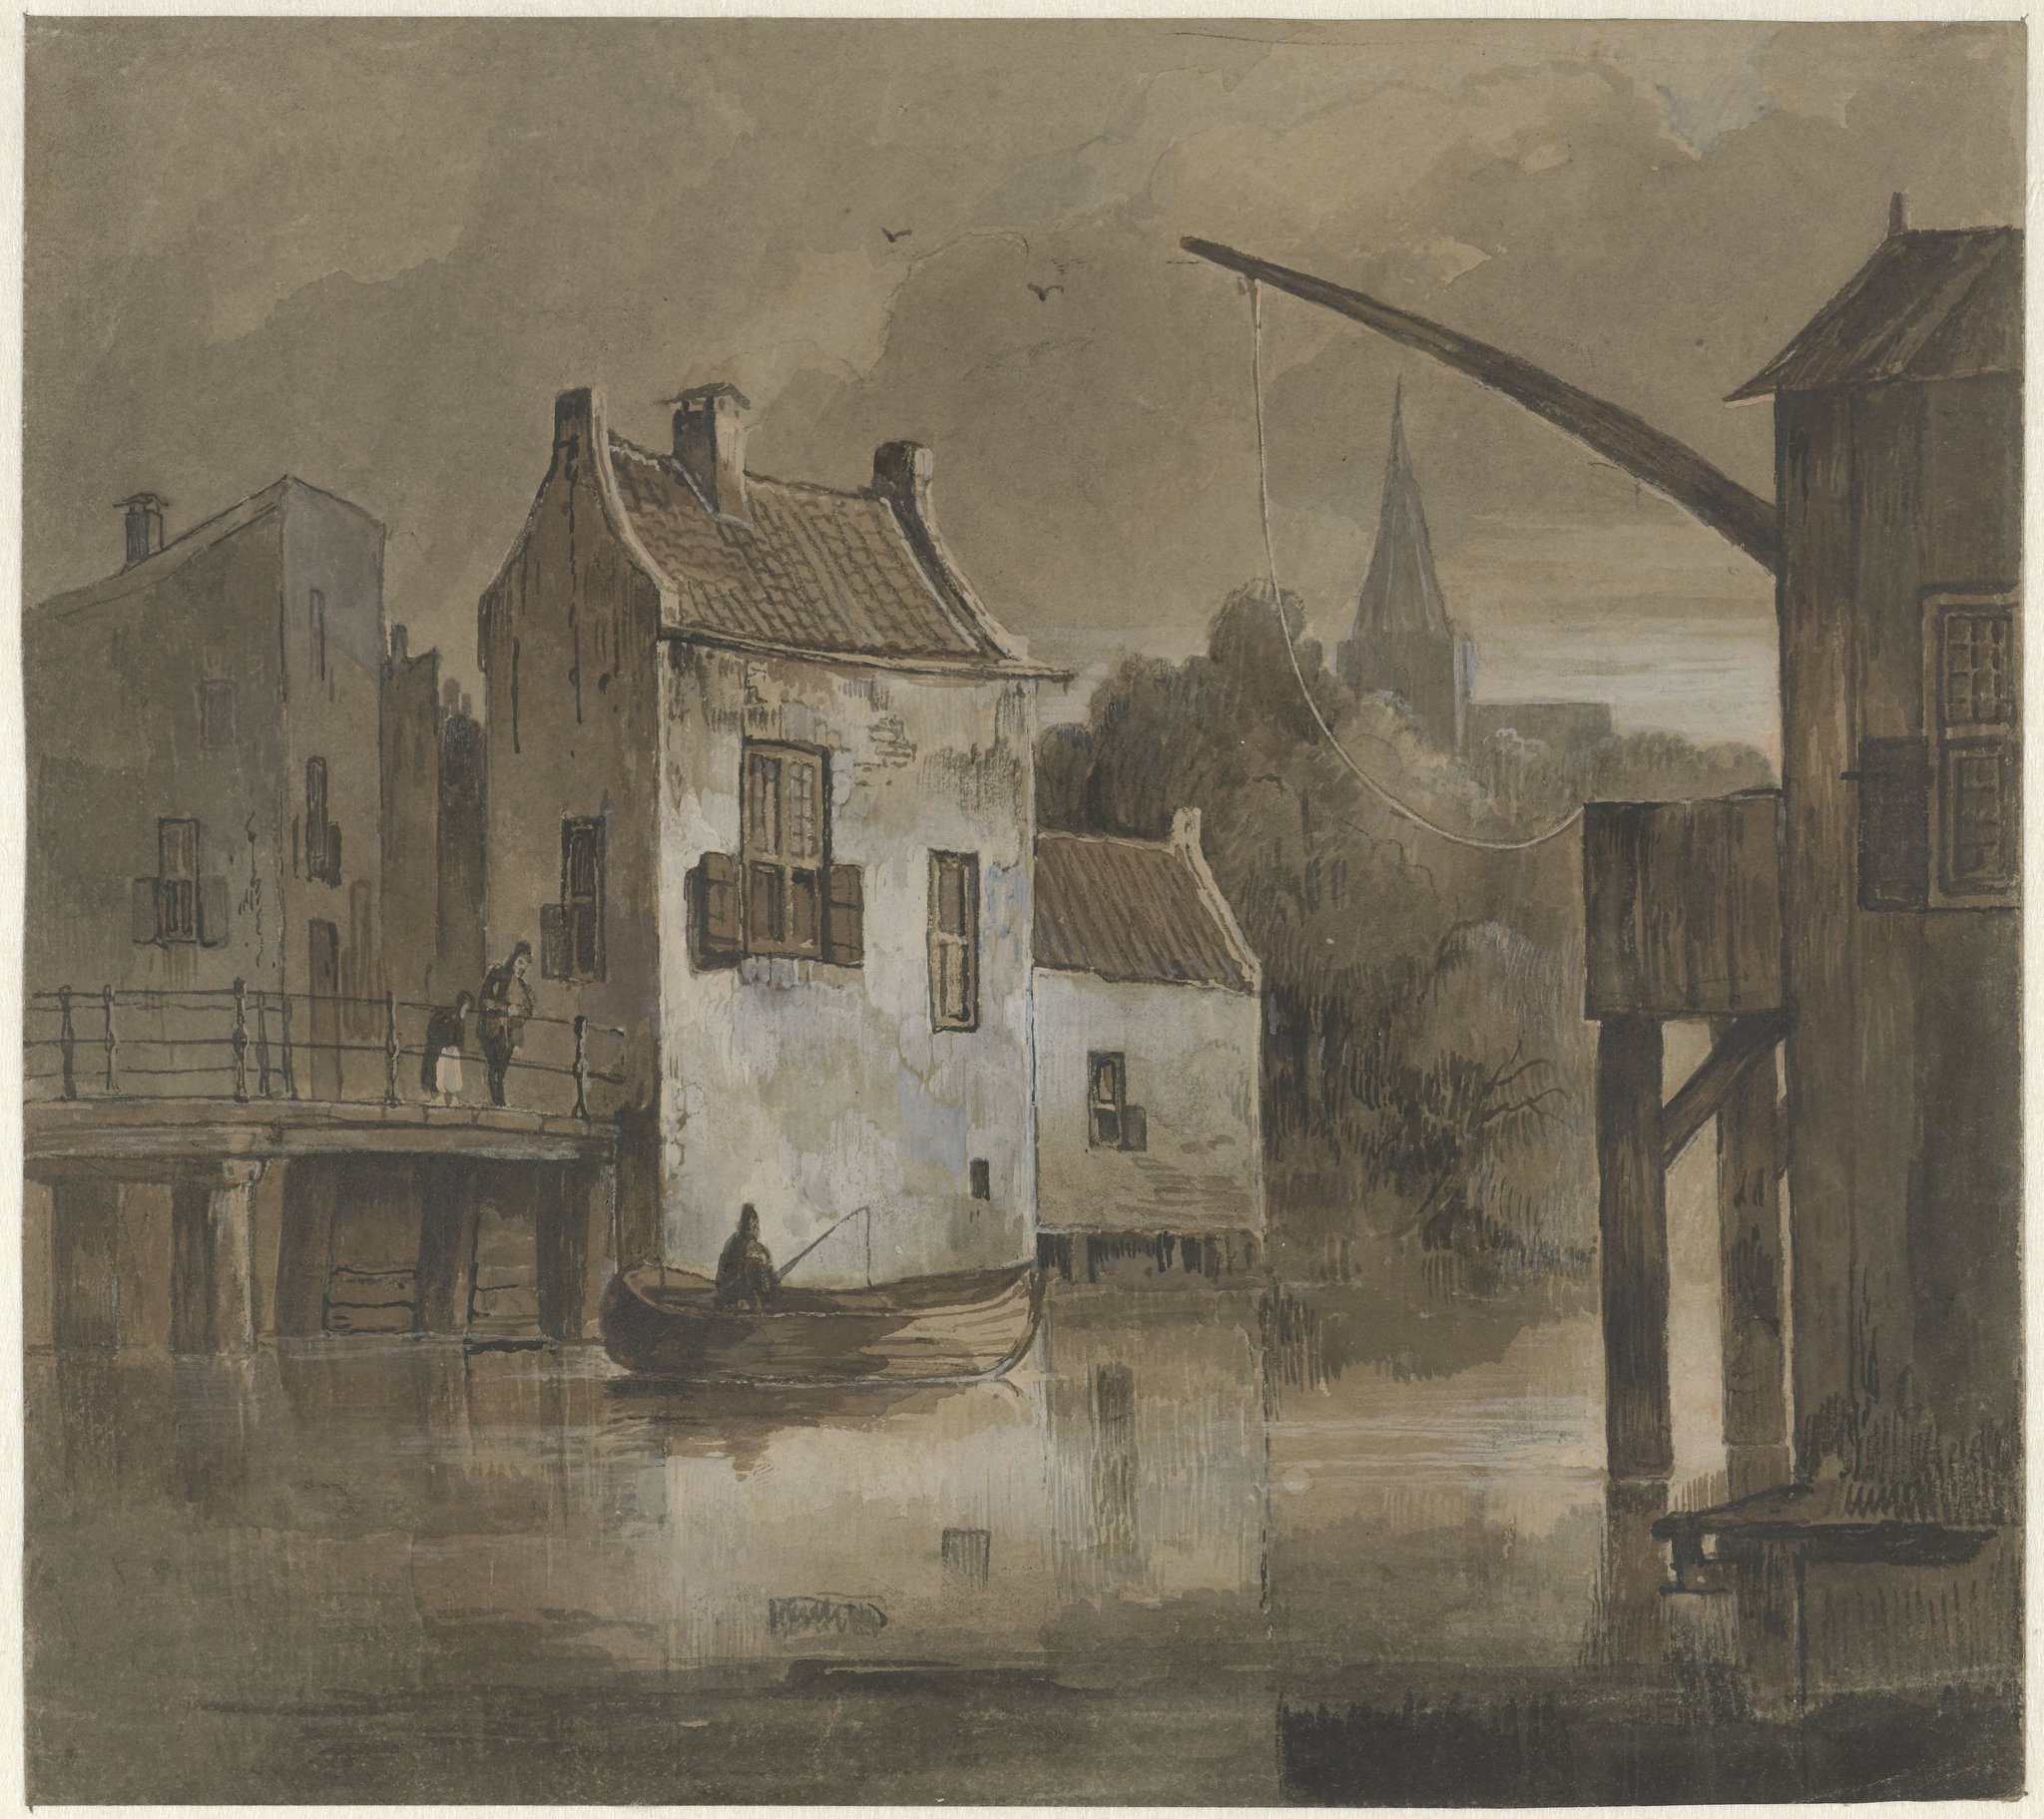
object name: drawing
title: Stadsgezicht, bij avond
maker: reinier craeyvanger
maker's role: draughtsman, print maker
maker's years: 1812-1880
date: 1822-1880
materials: paint, paper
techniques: brush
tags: canals, waters (in city)